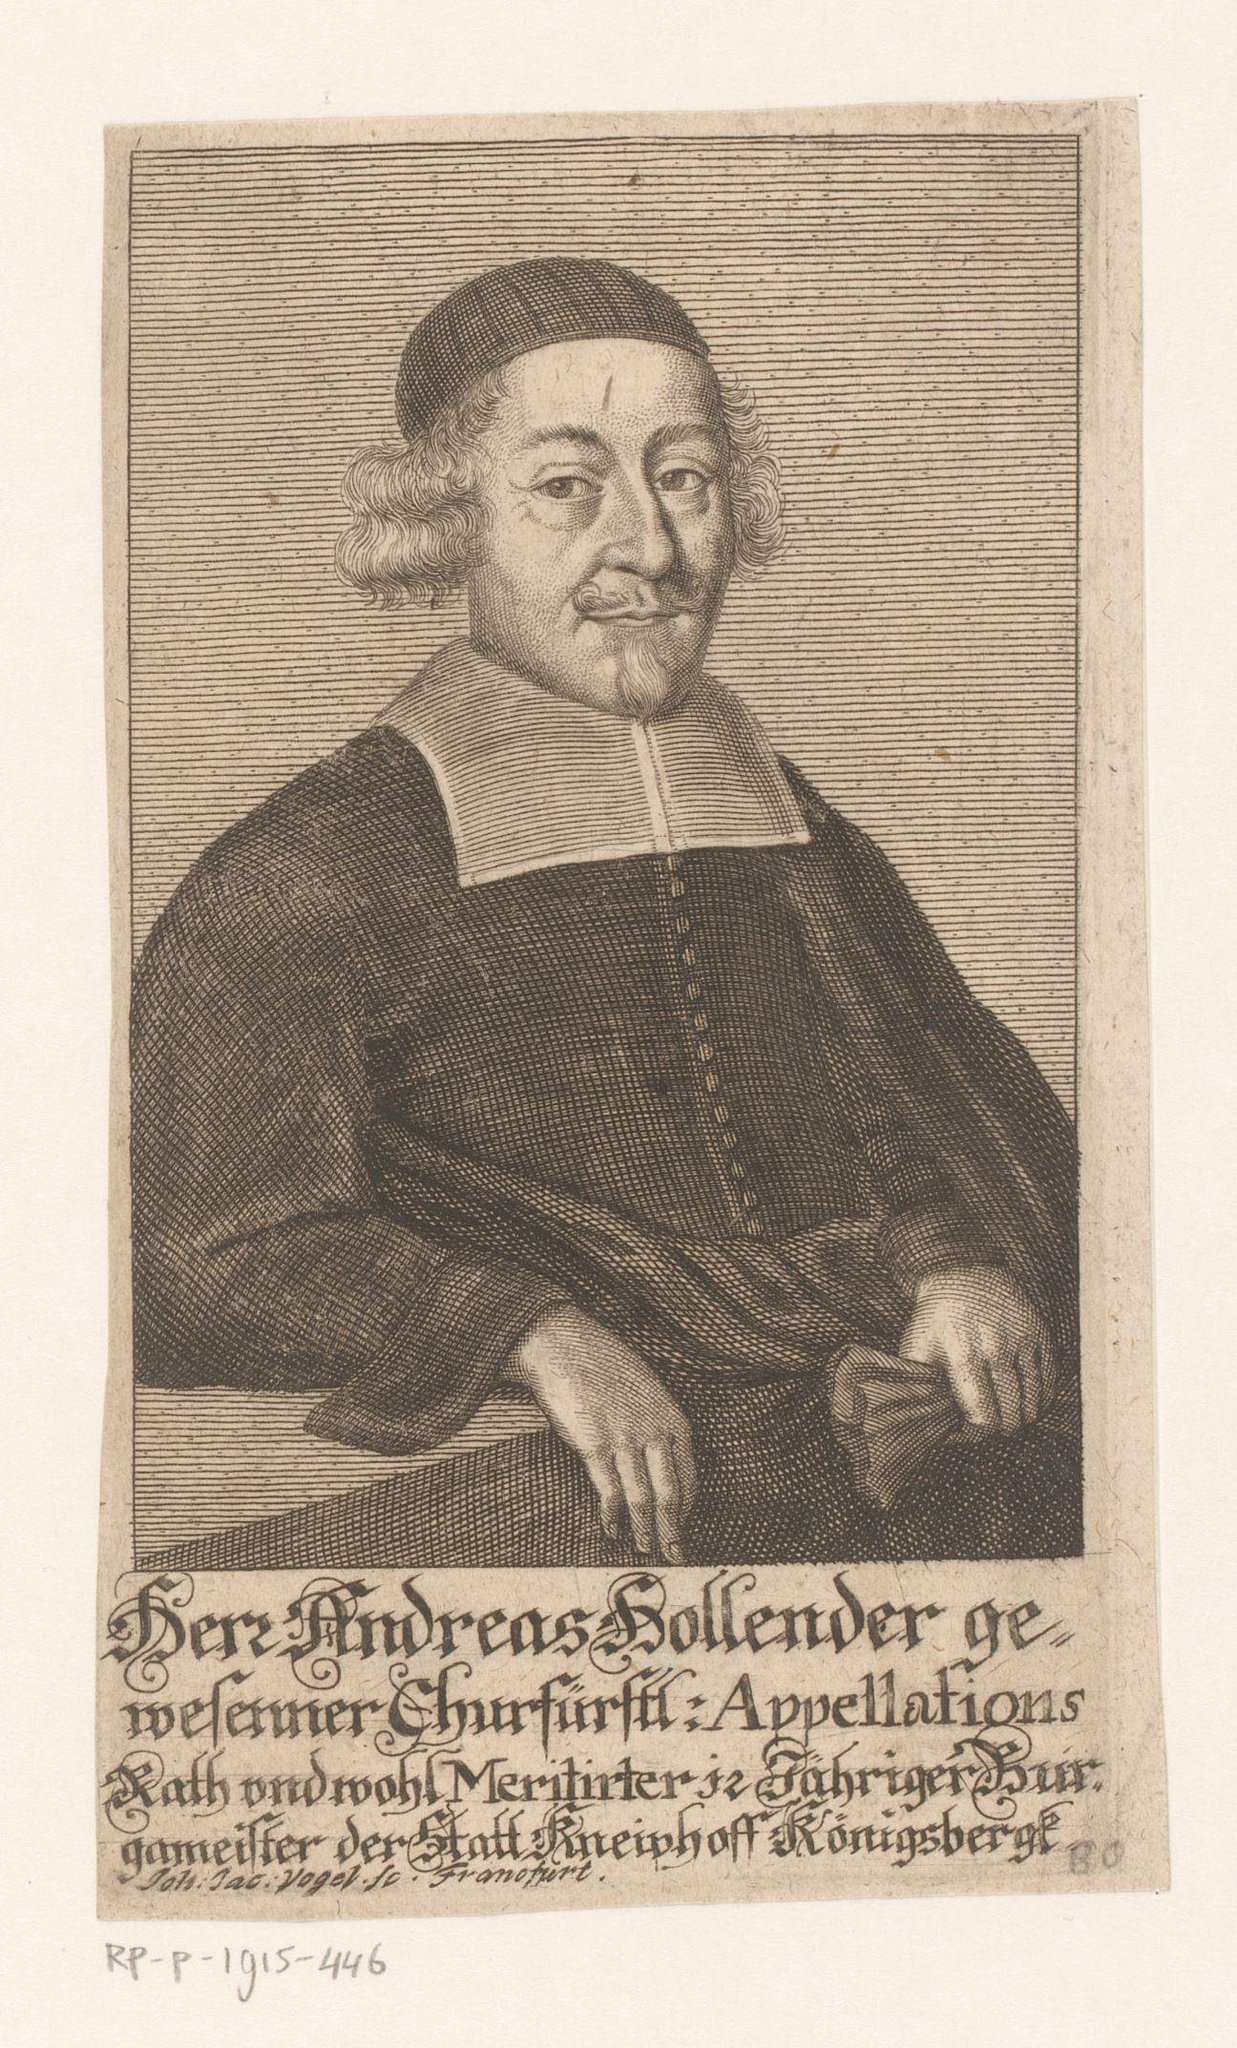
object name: print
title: Portret van Andreas Hollender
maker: johann jakob vogel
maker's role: clockmaker, print maker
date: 1693-1700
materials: paper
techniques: engraving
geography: frankfurt am main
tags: mayor, historical persons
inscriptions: collector's mark: Lugt 2228